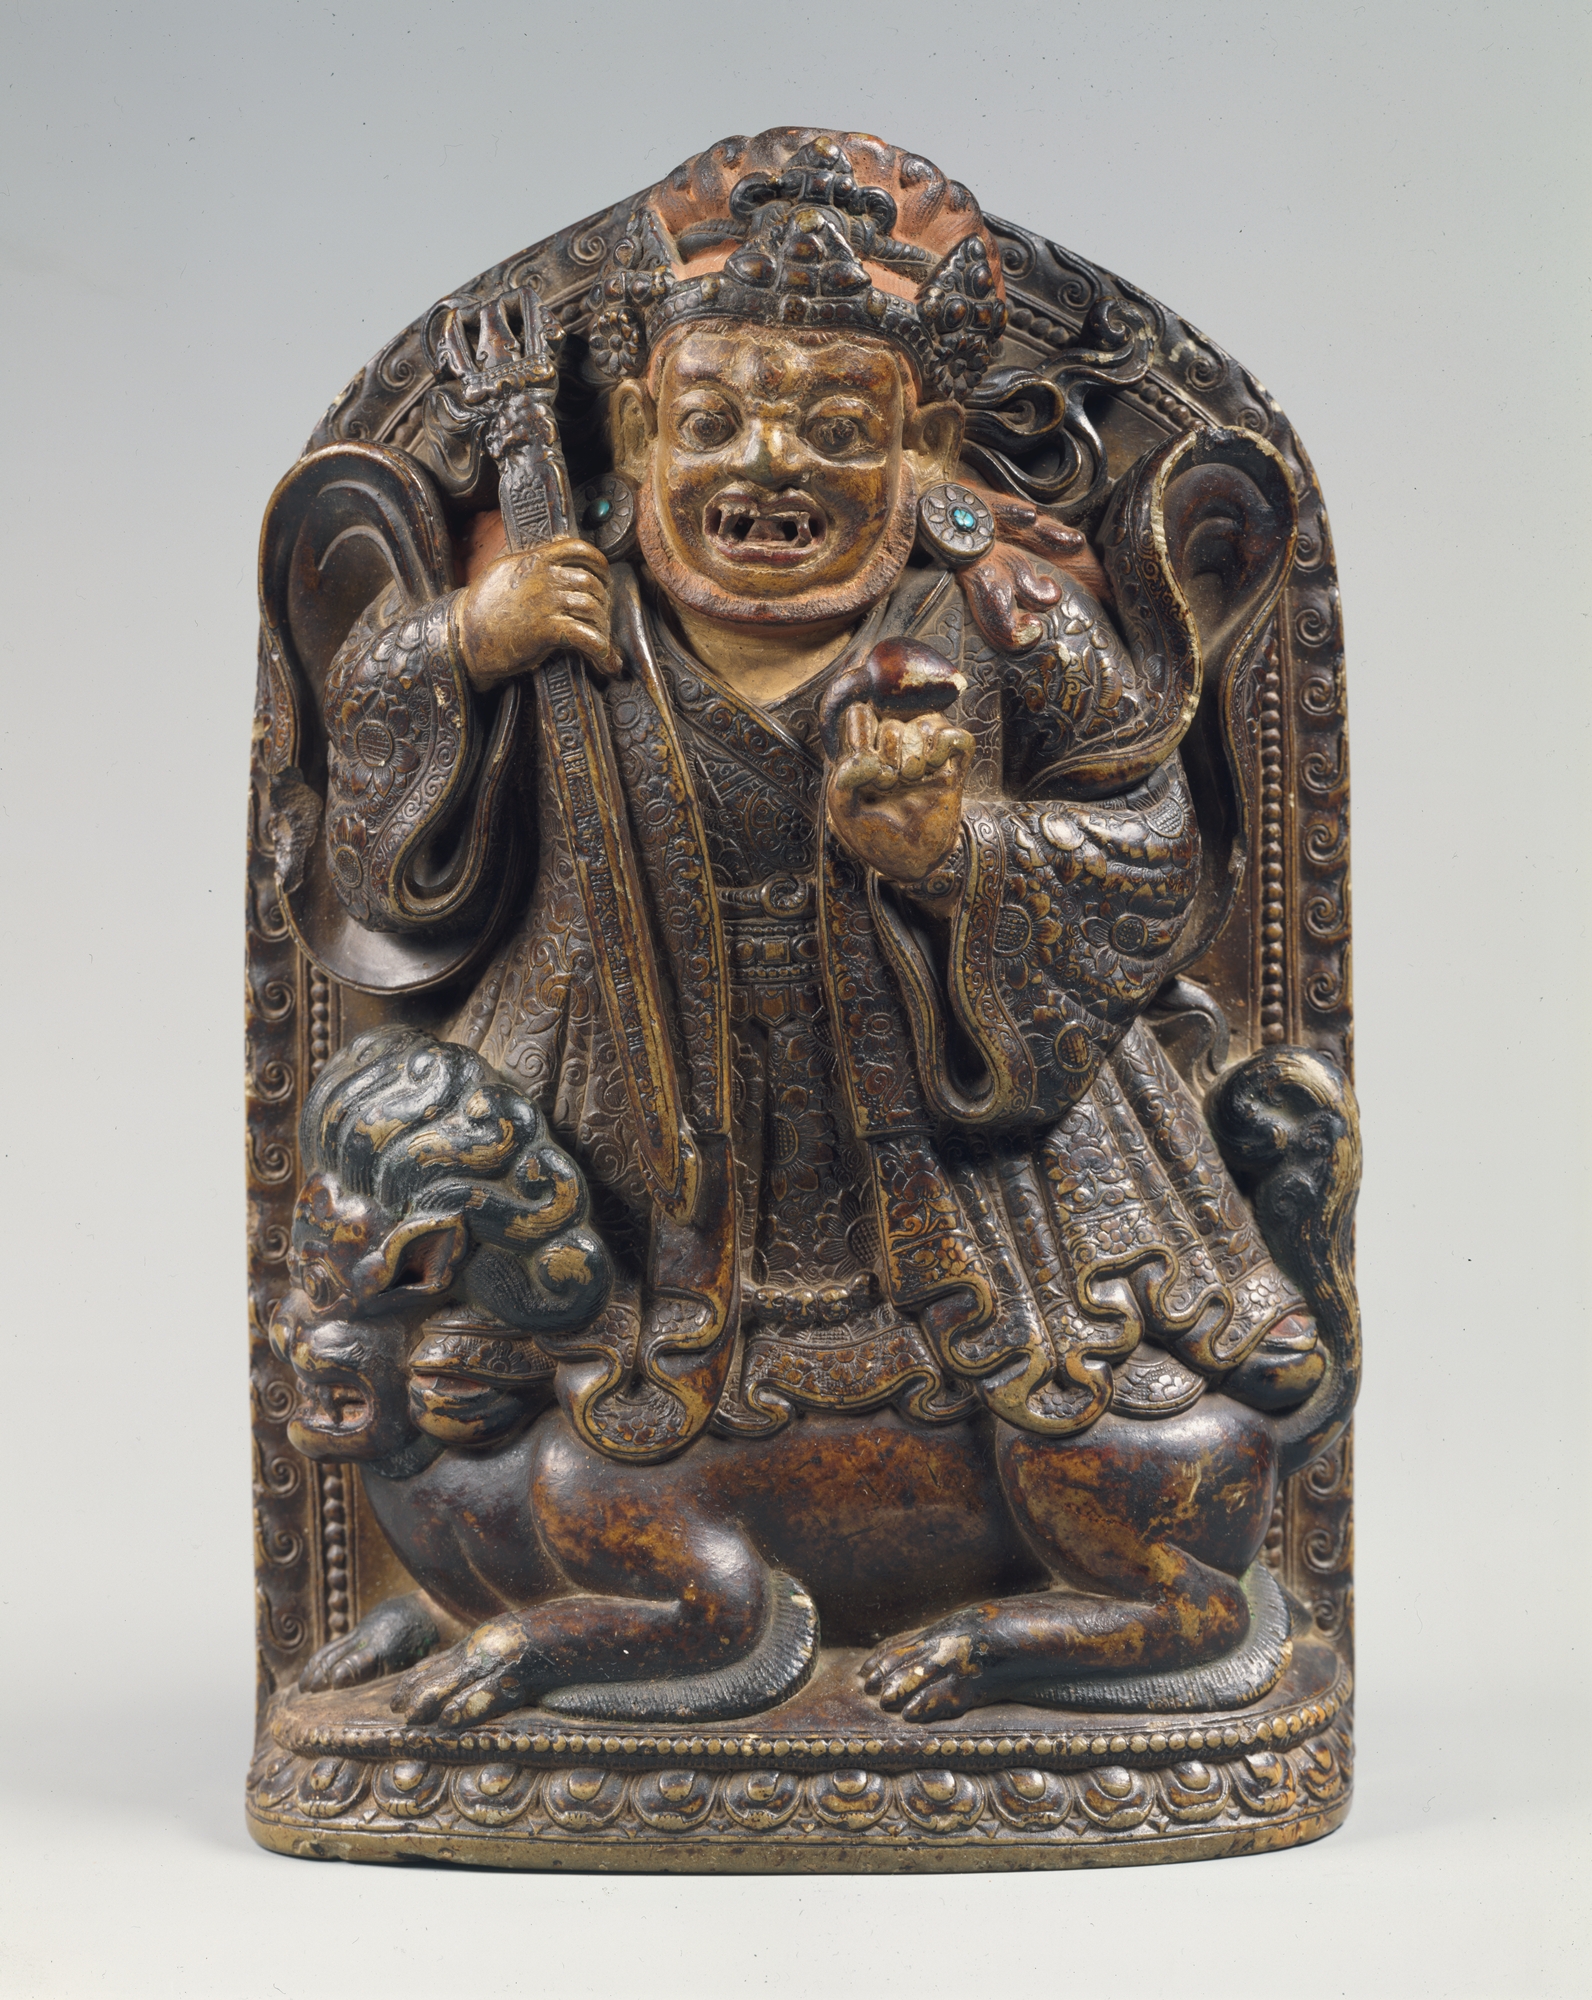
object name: stele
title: Dharmapala Standing on a Lion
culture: tibetan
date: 1501-1600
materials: gold paint, stone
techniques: inlay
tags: swords,men,lions,buddhism